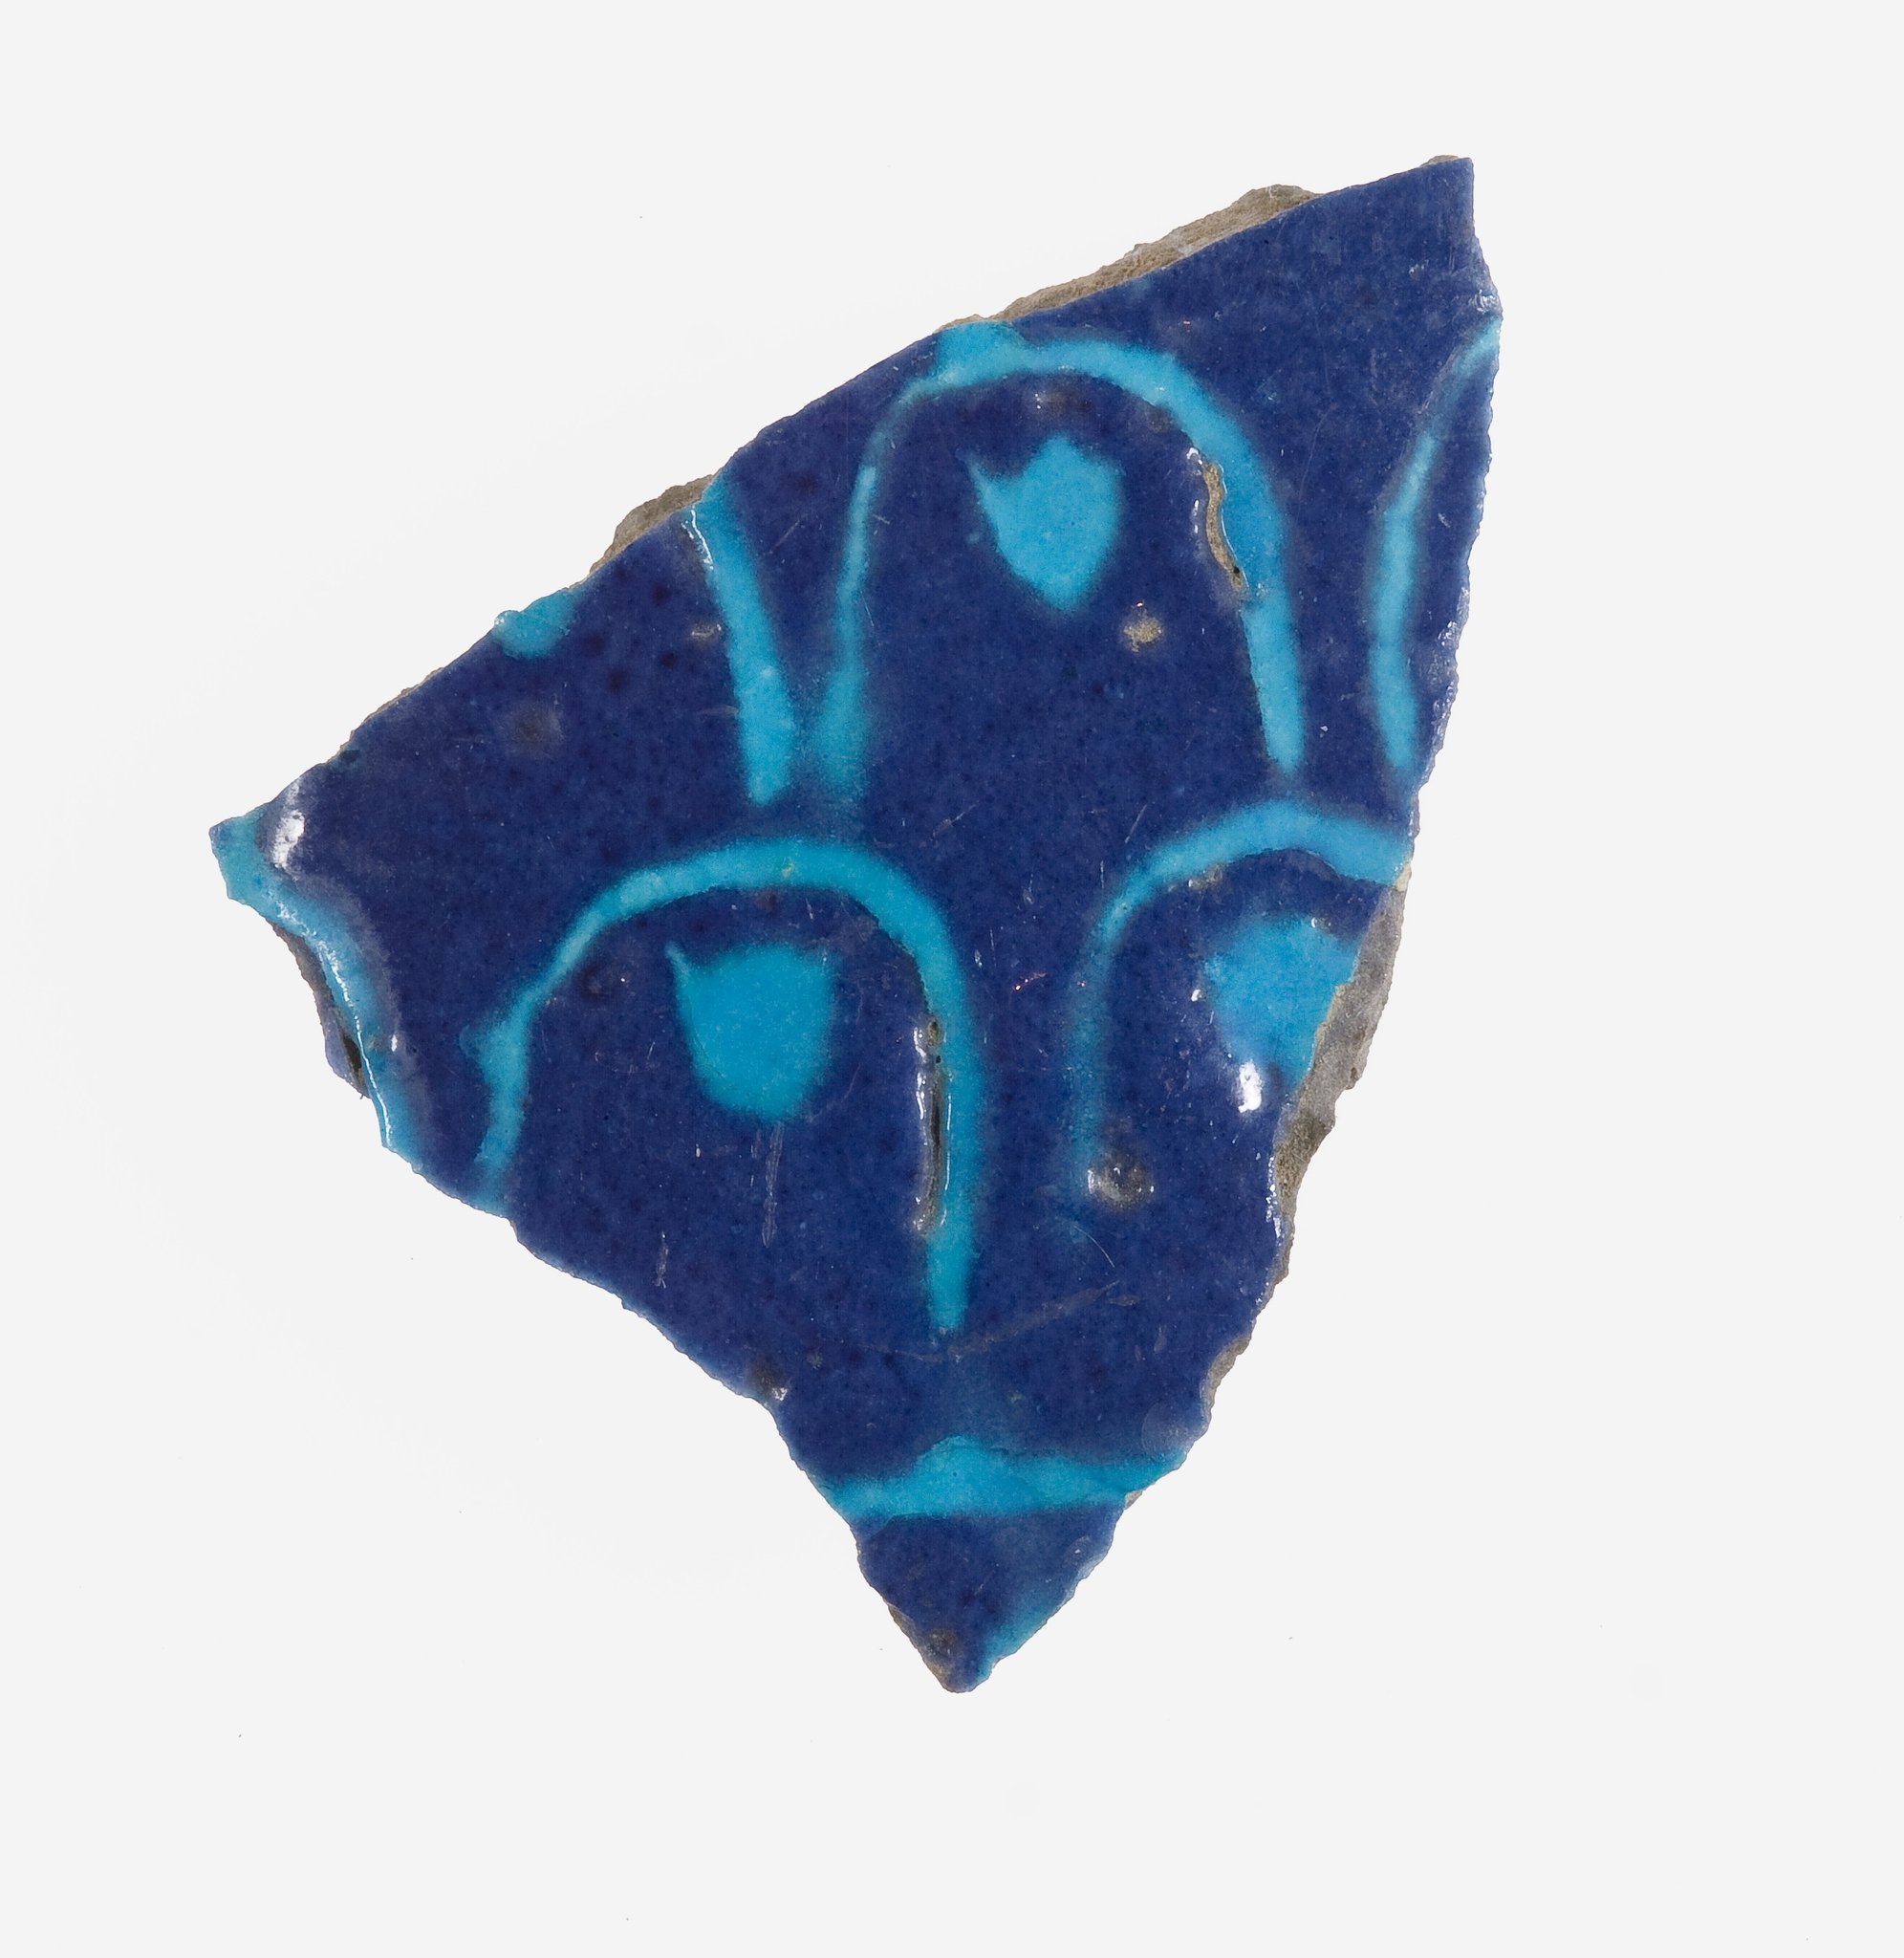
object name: vase fragment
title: Fragment of Vase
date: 1390-1352 BCE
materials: faience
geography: egypt